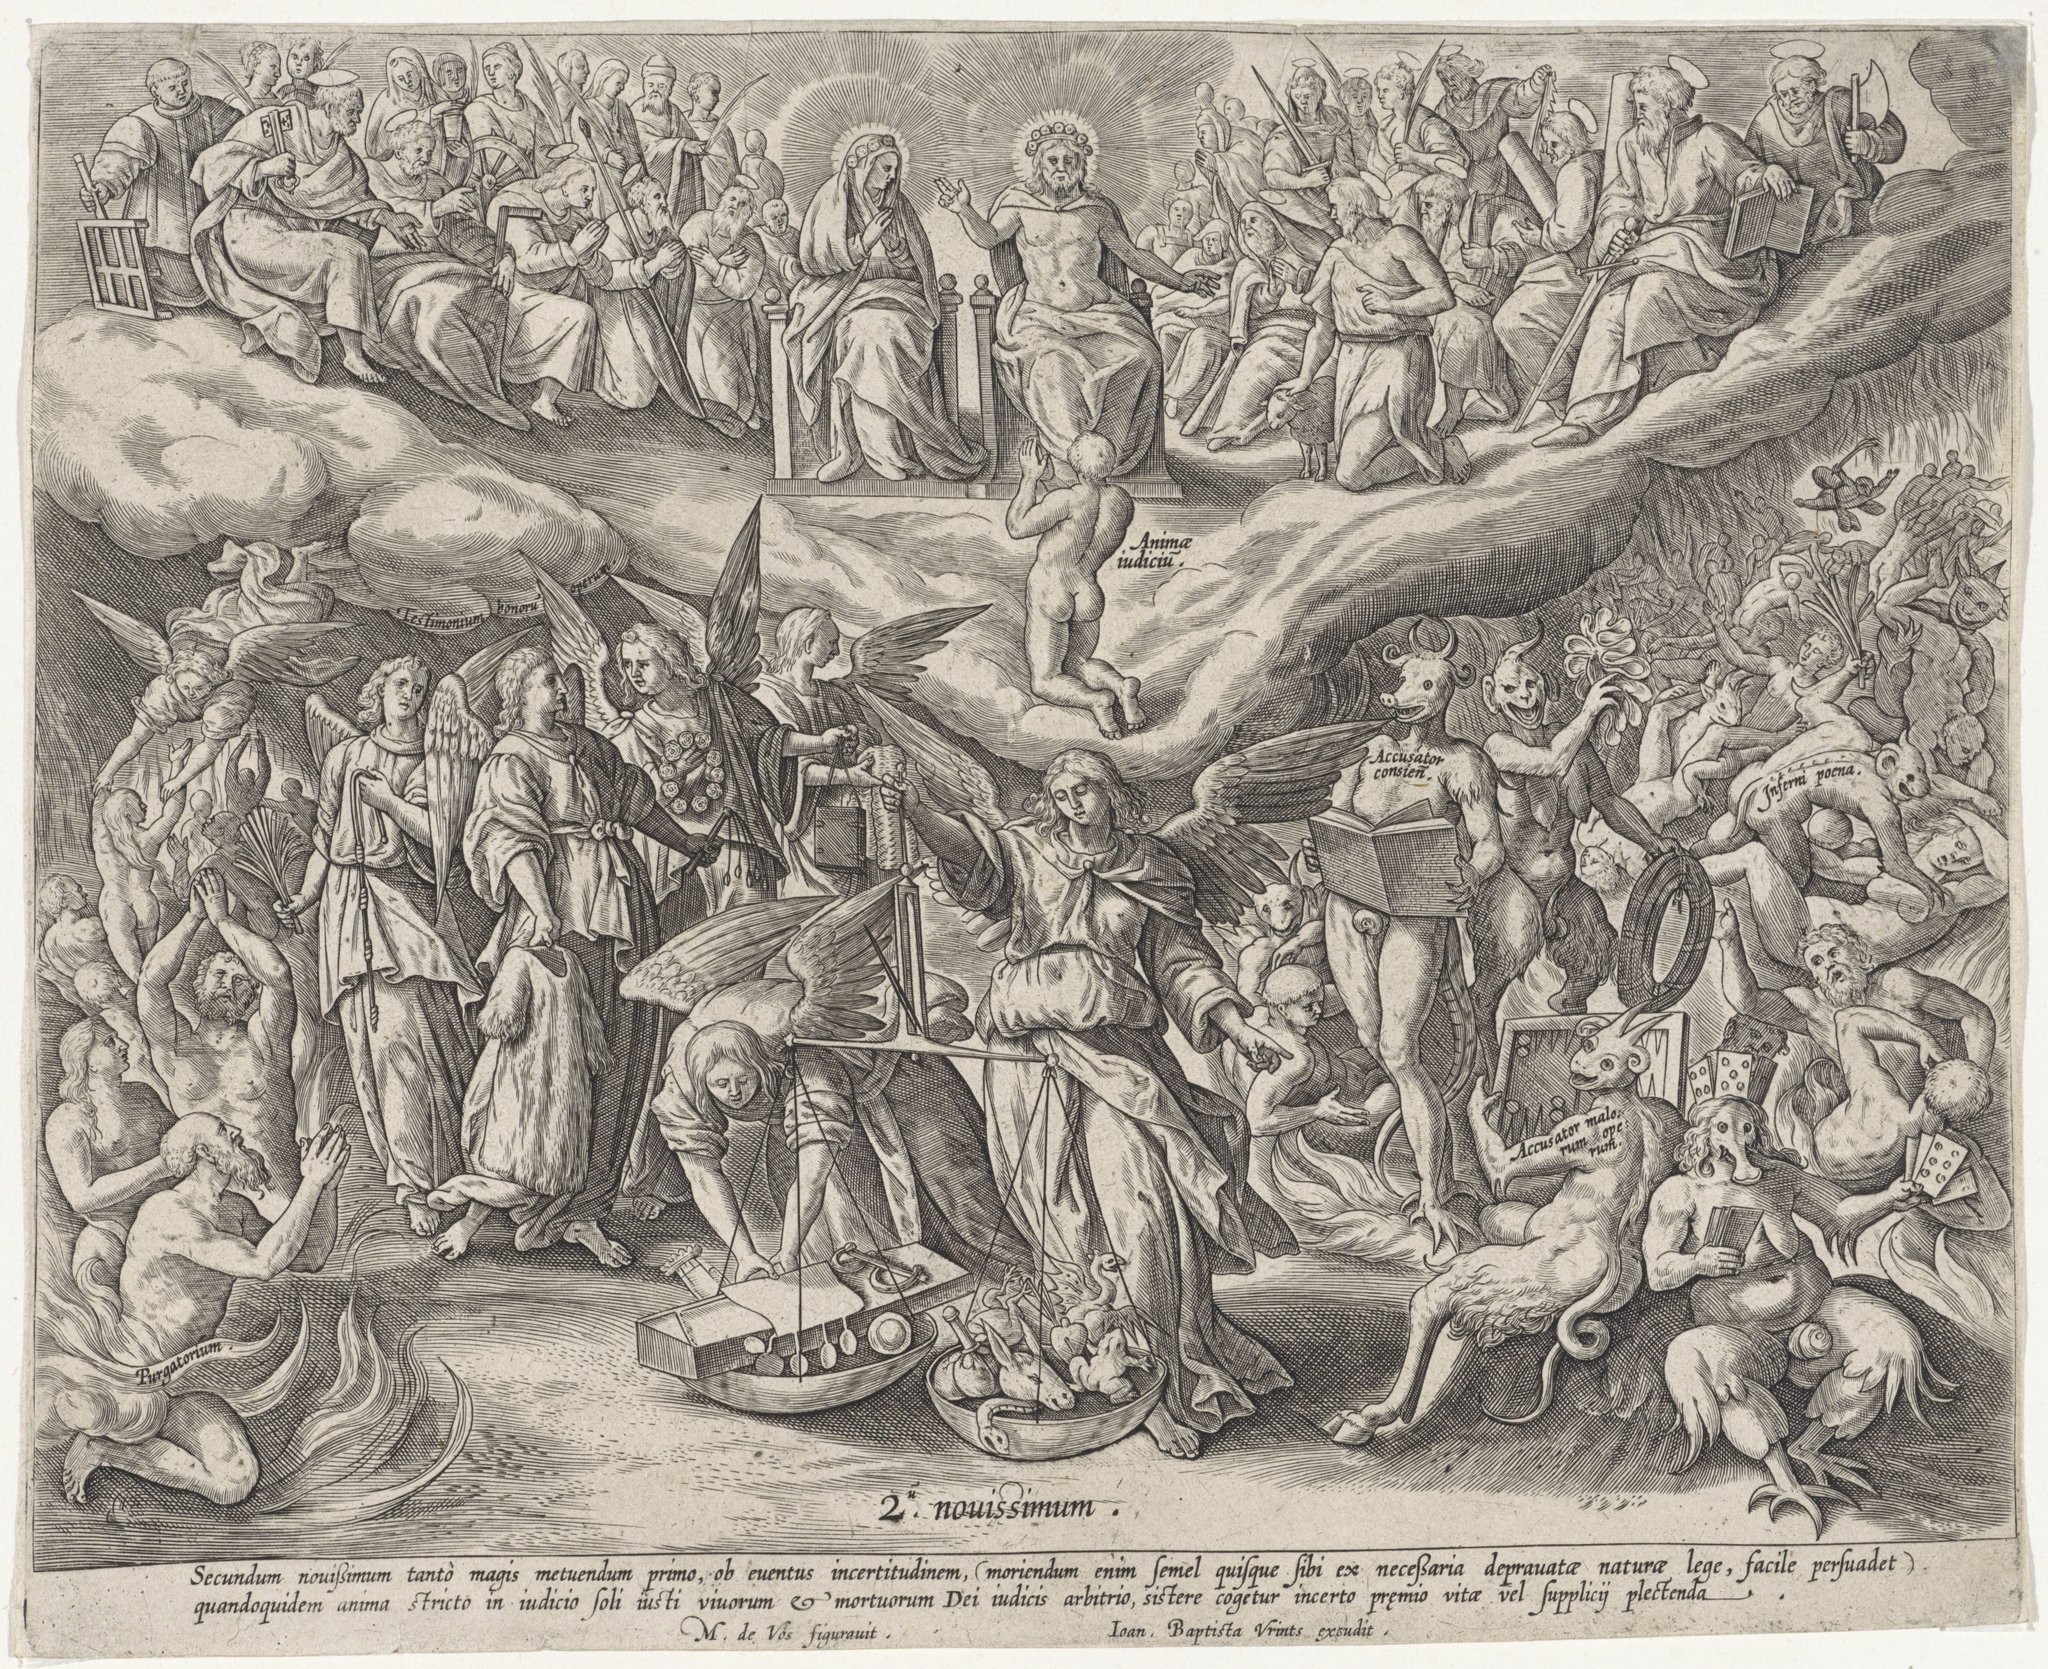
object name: print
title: Laatste Oordeel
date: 1575-1610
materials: paper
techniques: engraving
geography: antwerp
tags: representation of last judgement, with the archangel michael weighing the souls (or dividing the blessed and the damned)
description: Boven tronen Maria en Christus. Ze worden geflankeerd door de apostelen en enkele andere heiligen. Voor hen knielt een naakte man. Onder weegt de aartsengel Michaël de zielen van de doden. Linksvoor enkele figuren in het vagevuur. Daarachter engelen met geselinstrumenten. Achter de engelen trekt een engel de goede zielen omhoog. Rechts straffen demonen de slechte zielen in de hel. Onder in de marge een tweeregelige tekst in het Latijn.